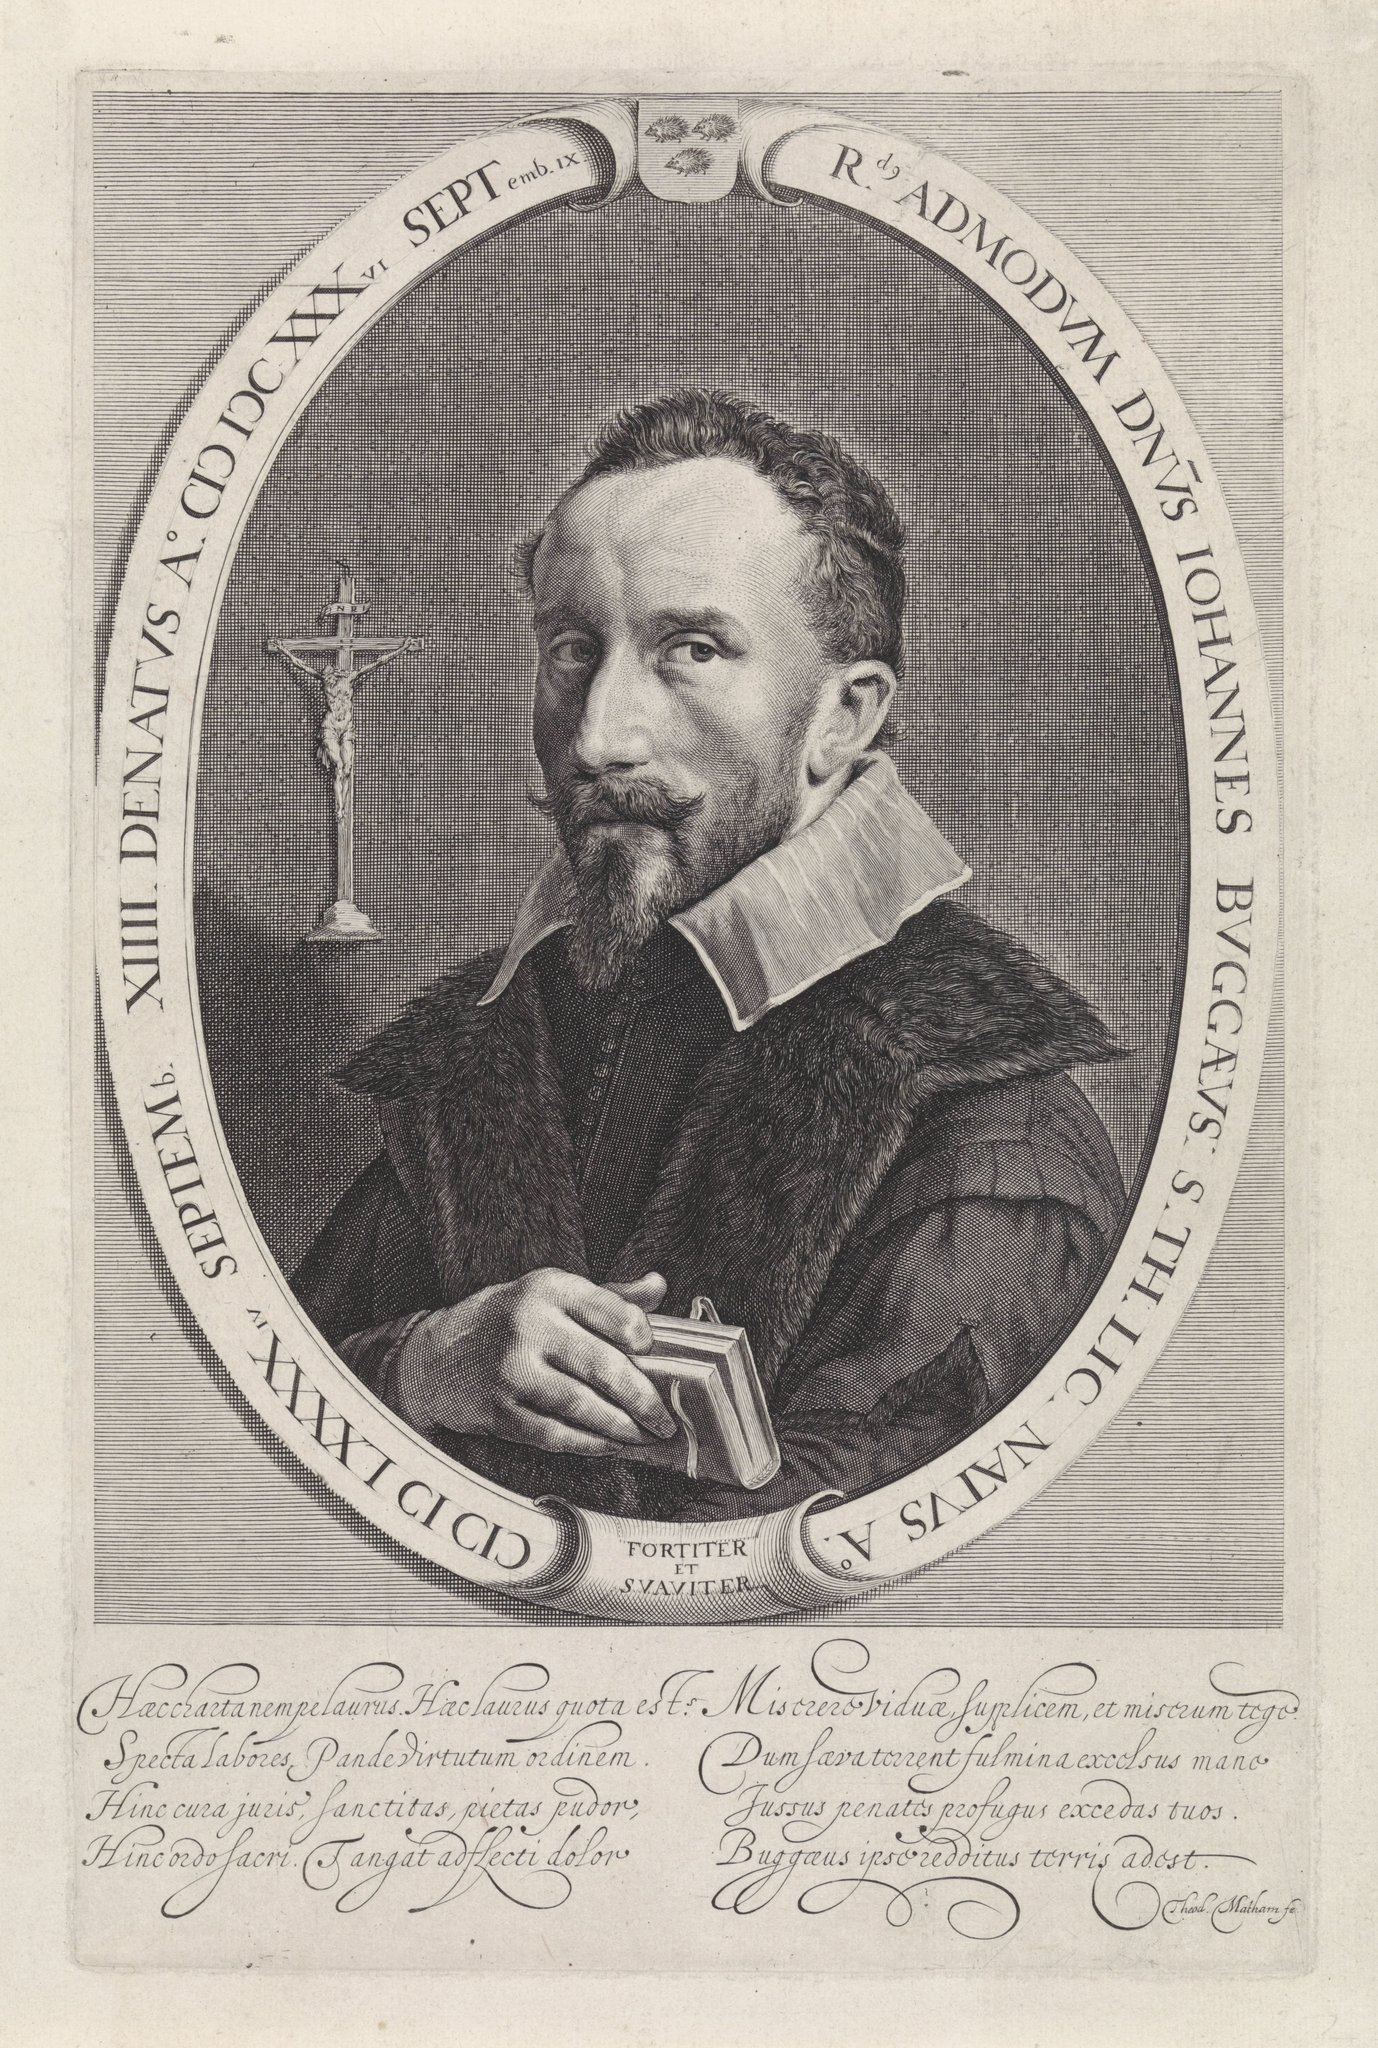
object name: print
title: Portret van Johannes Buggaeus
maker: theodor matham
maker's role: draughtsman, print maker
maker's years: 1605-1676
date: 1636-1676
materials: paper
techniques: engraving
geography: northern netherlands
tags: crucifix ~ personal devotion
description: Portret van de theoloog Johannes Buggaeus, met in zijn hand een bijbel en achter hem een crucifix.